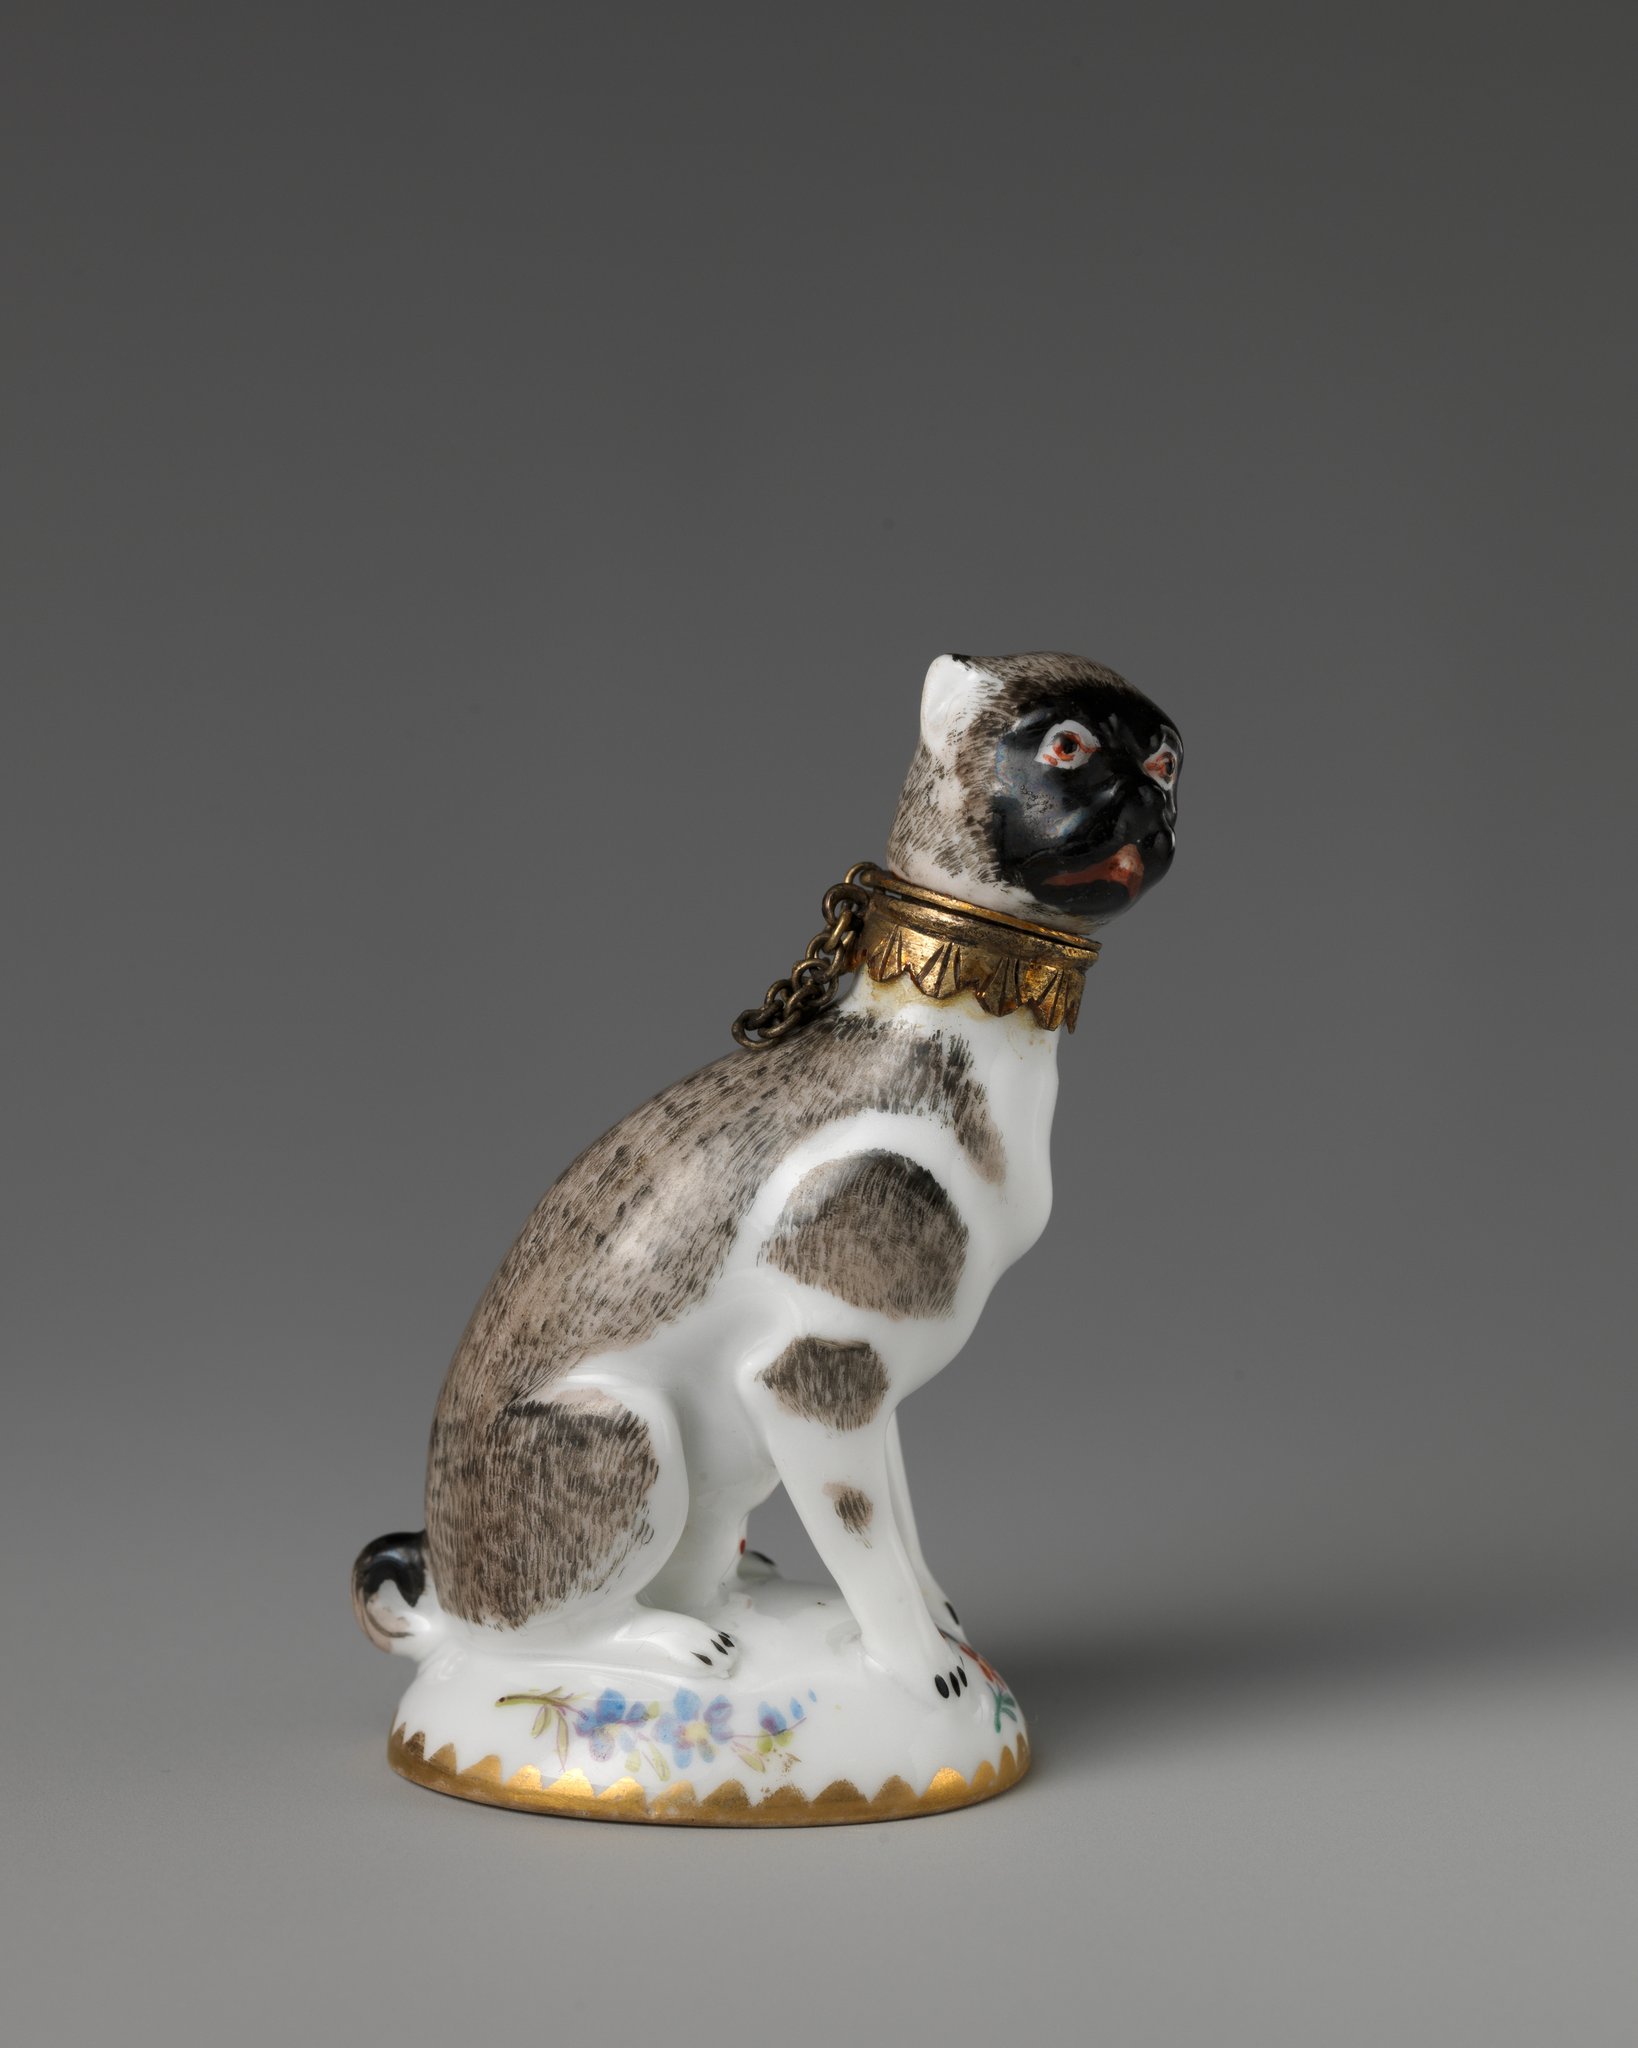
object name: toy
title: Dog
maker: chelsea porcelain manufactory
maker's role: factory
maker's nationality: british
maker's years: 1744-1784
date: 1867-1933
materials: soft paste porcelain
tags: dogs